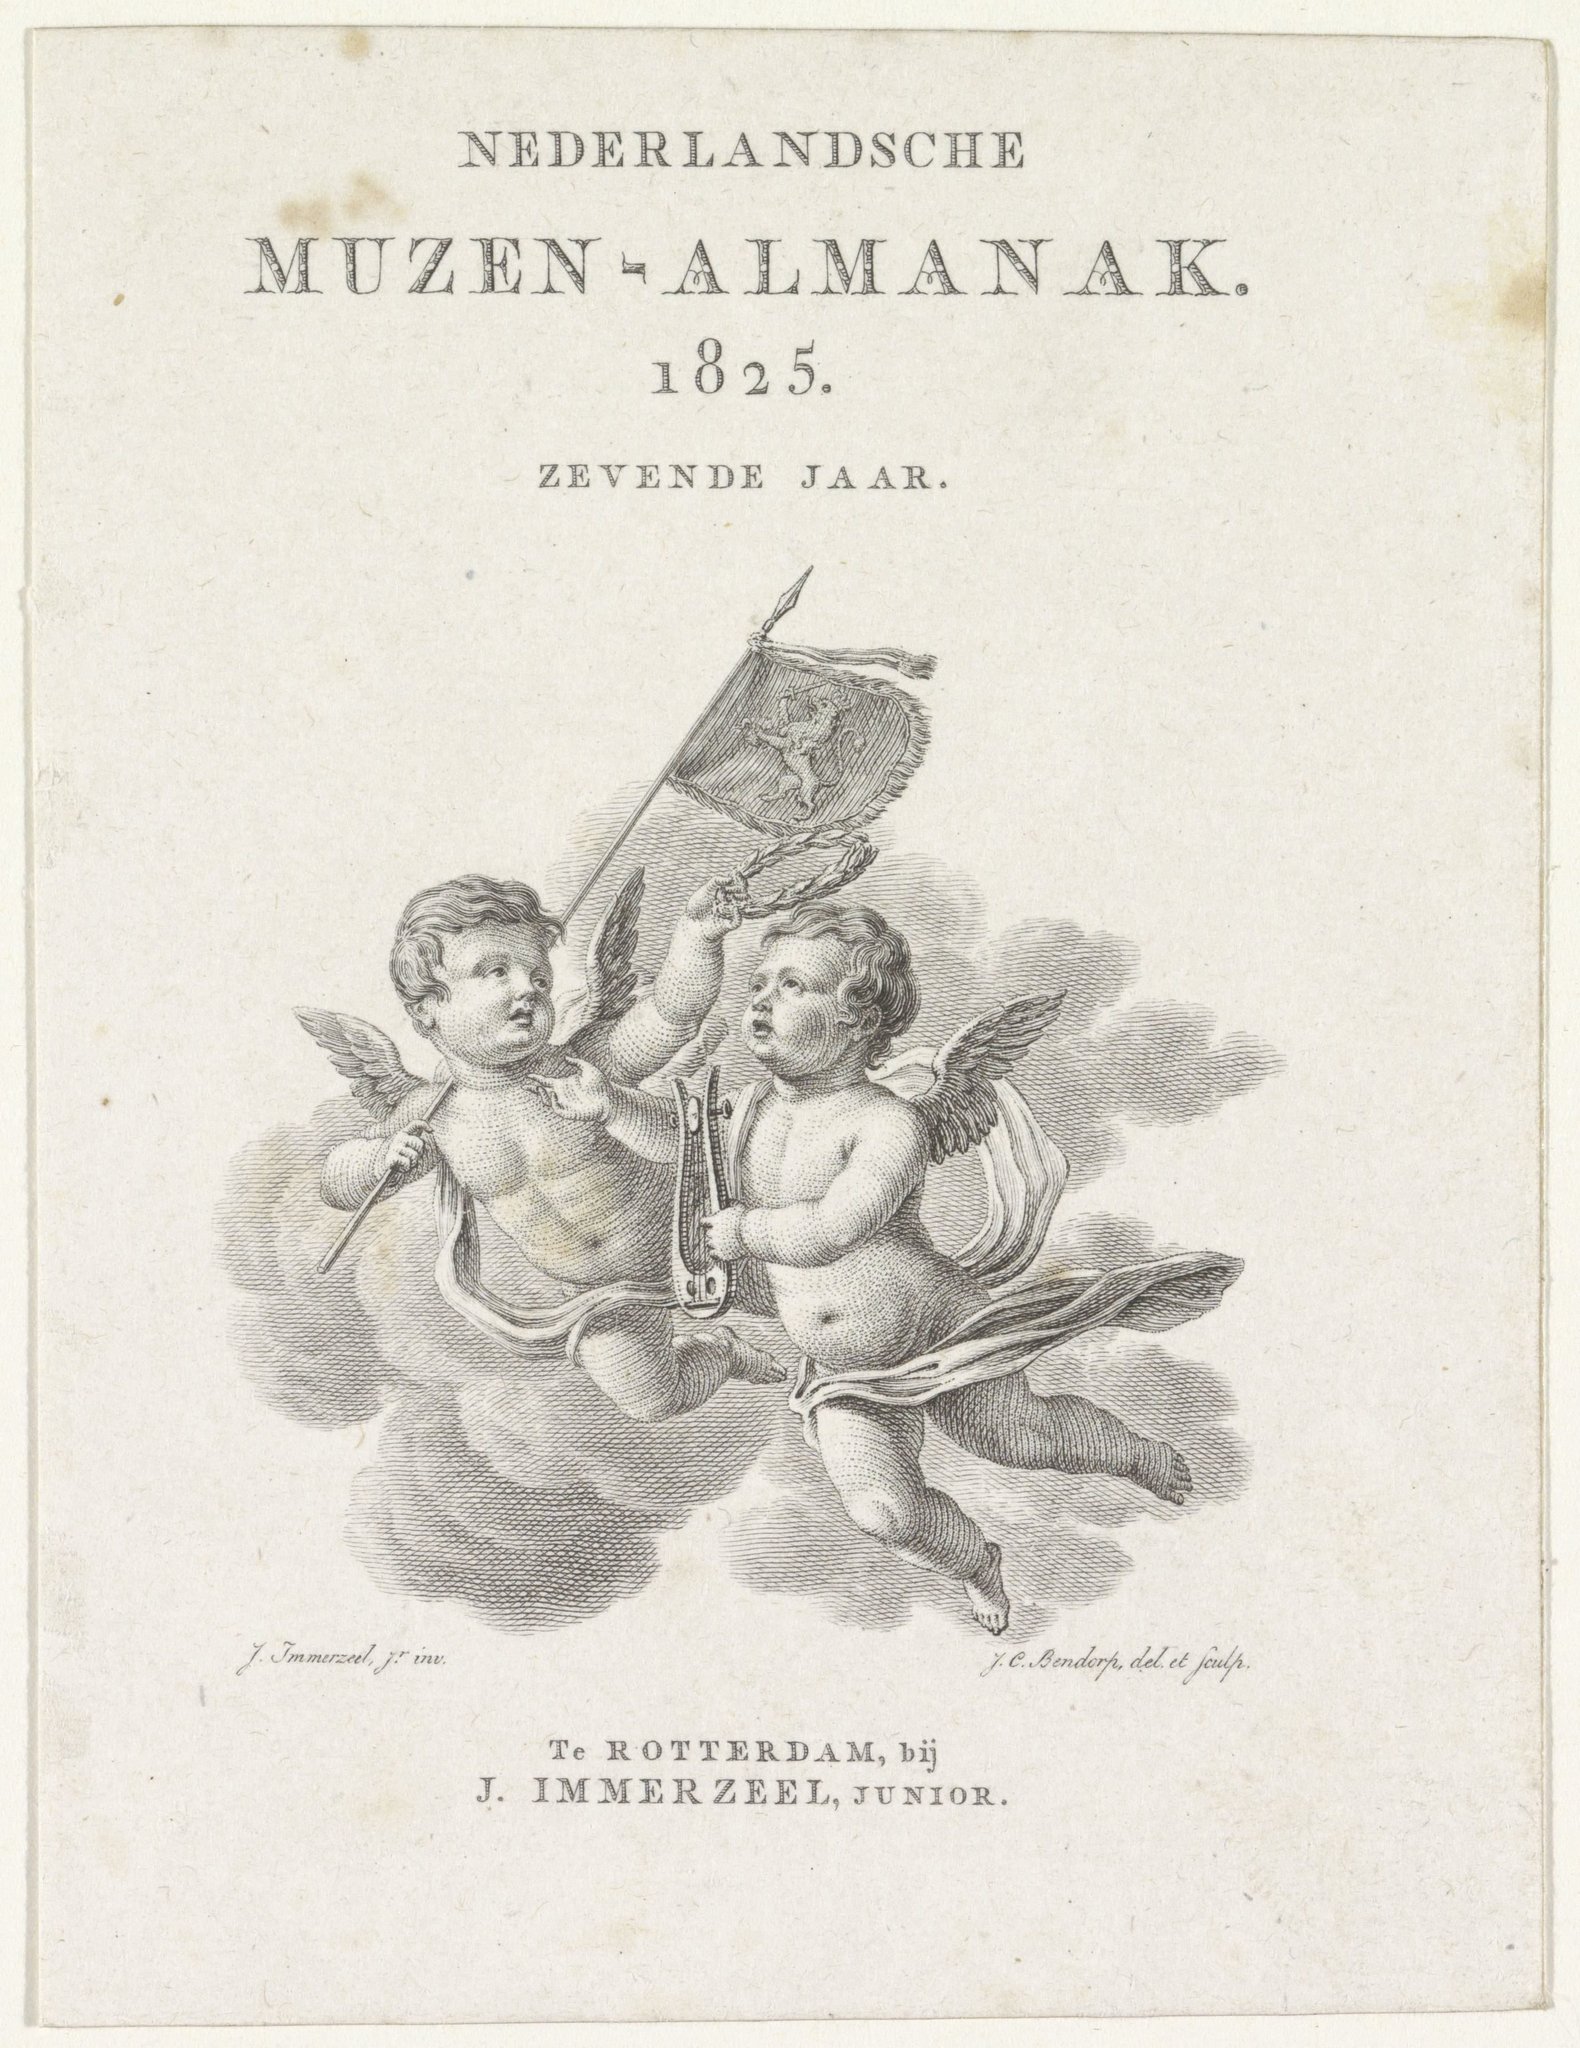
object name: print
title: Titelpagina voor: Nederlandsche Muzen-Almanak 1825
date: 1825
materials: paper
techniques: etching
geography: rotterdam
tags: cupids: 'amores', 'amoretti', 'putti', symbols of particular nations, states, districts, etc.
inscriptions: collector's mark: Lugt 2228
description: Titelpagina voor: Nederlandsche Muzen-Almanak 1825, Johannes Immerzeel (uitgever), zevende jaar, Rotterdam 1825